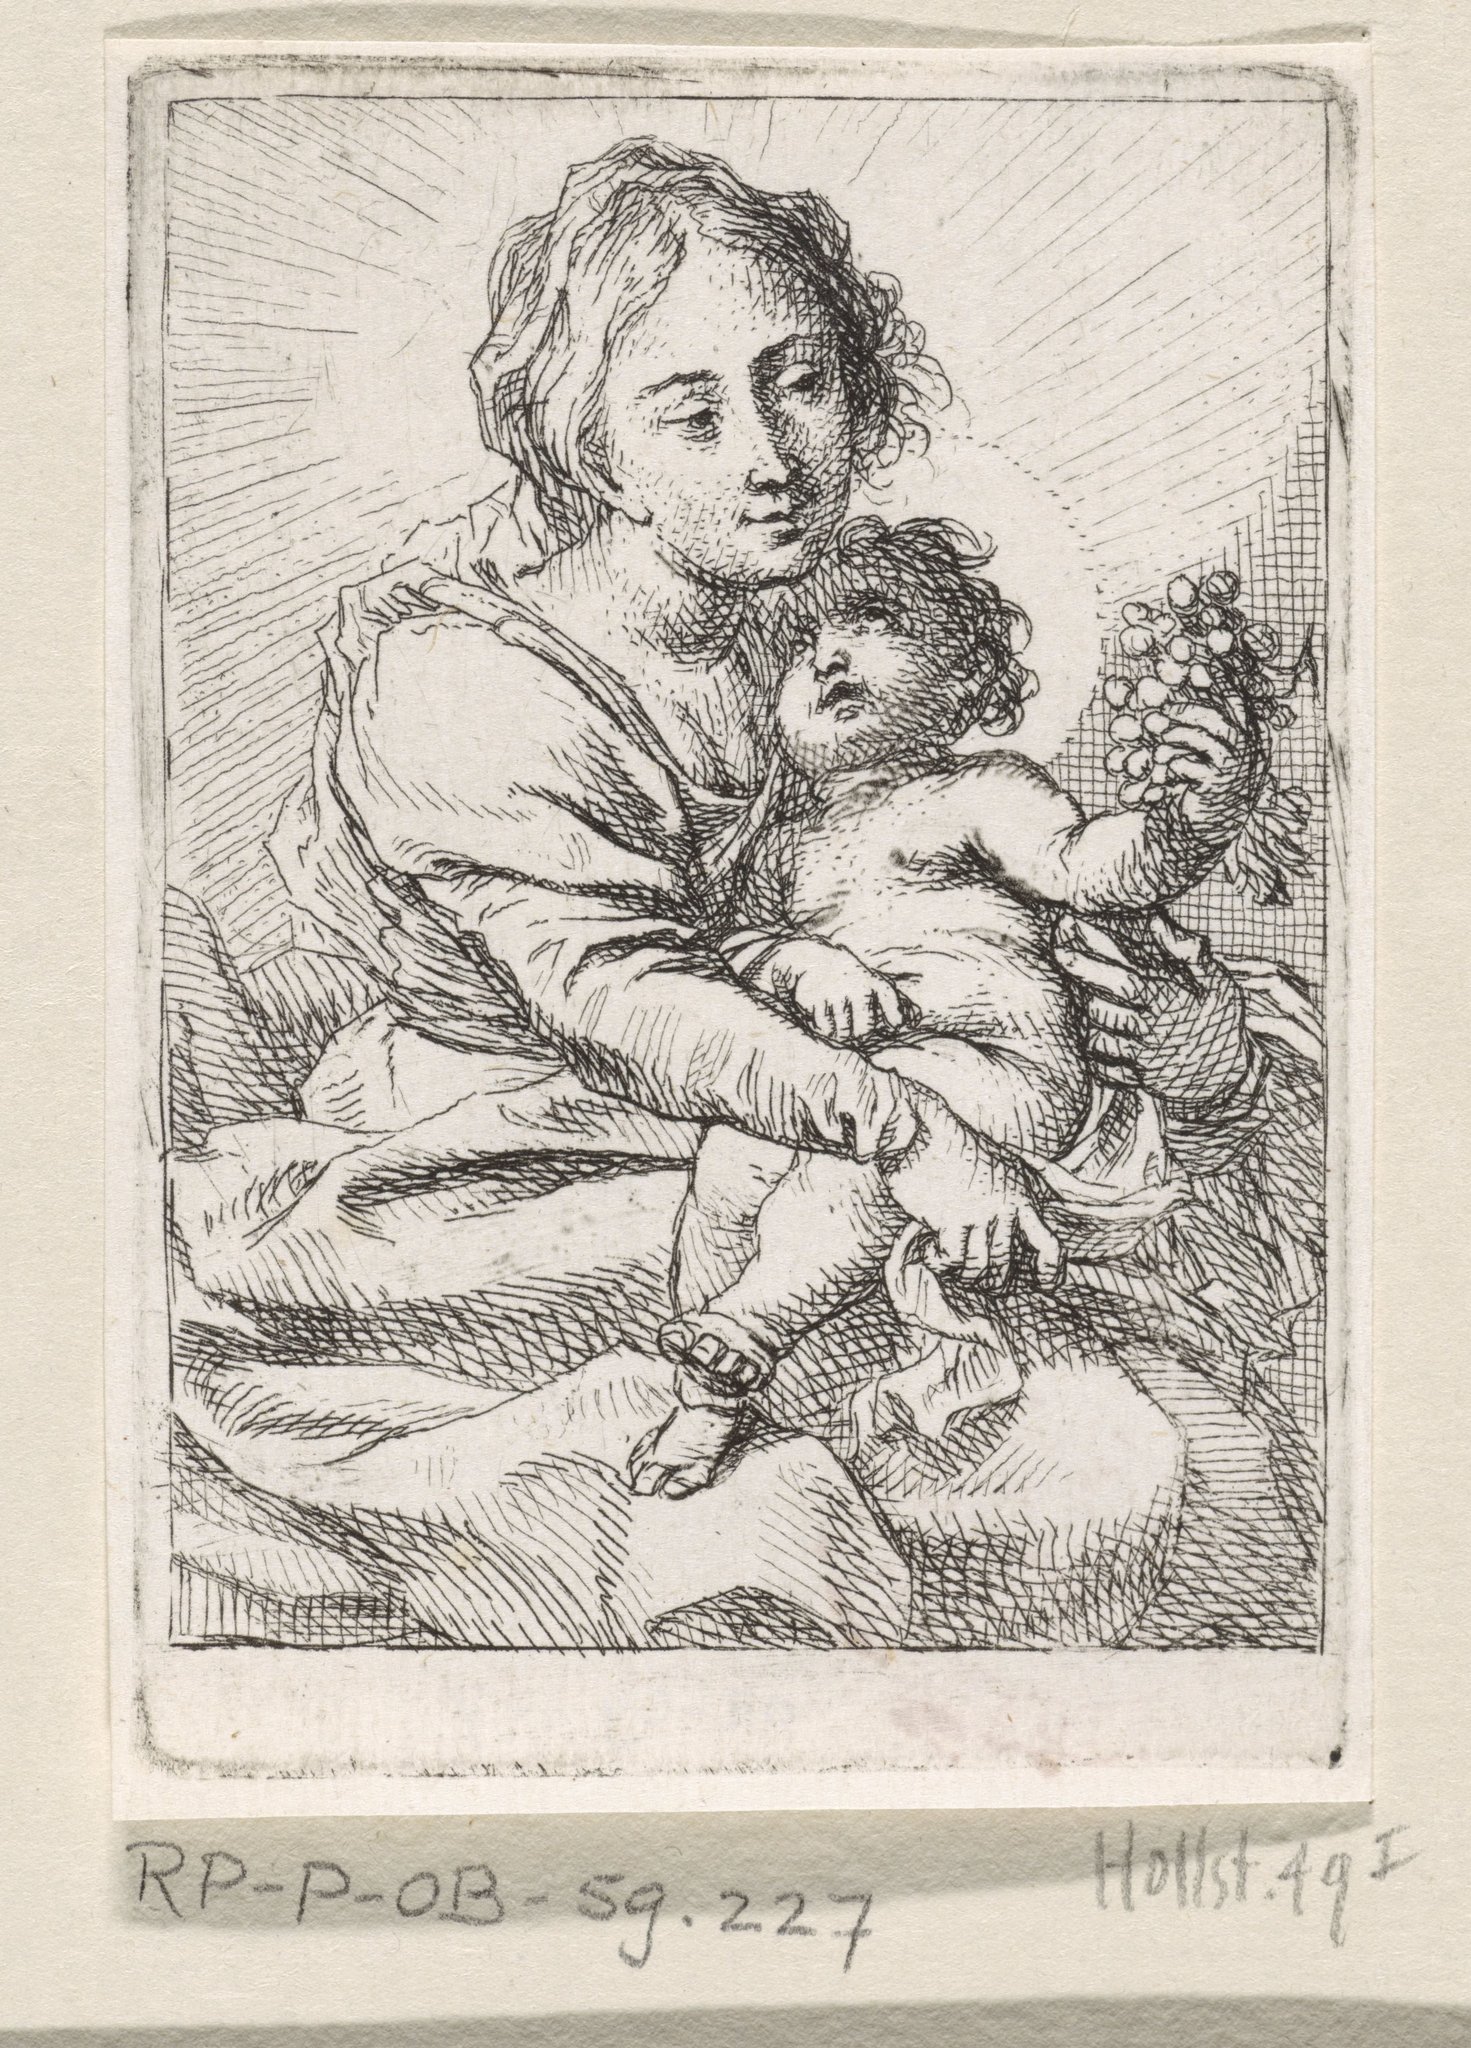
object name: print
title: Madonna met kind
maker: cornelis schut (i)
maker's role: draughtsman, print maker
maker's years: 1597-1655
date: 1618-1655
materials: paper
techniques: etching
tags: christ-child holding something in his hand, e.g. apple, bird, cherries, crucifix, grapes, paper wind-mill ~ madonna-representations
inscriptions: collector's mark: Lugt 240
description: Maria heeft het Christuskind op schoot. Hij leunt met zijn hoofd tegen haar schouder. In zijn hand heeft hij een druiventros.